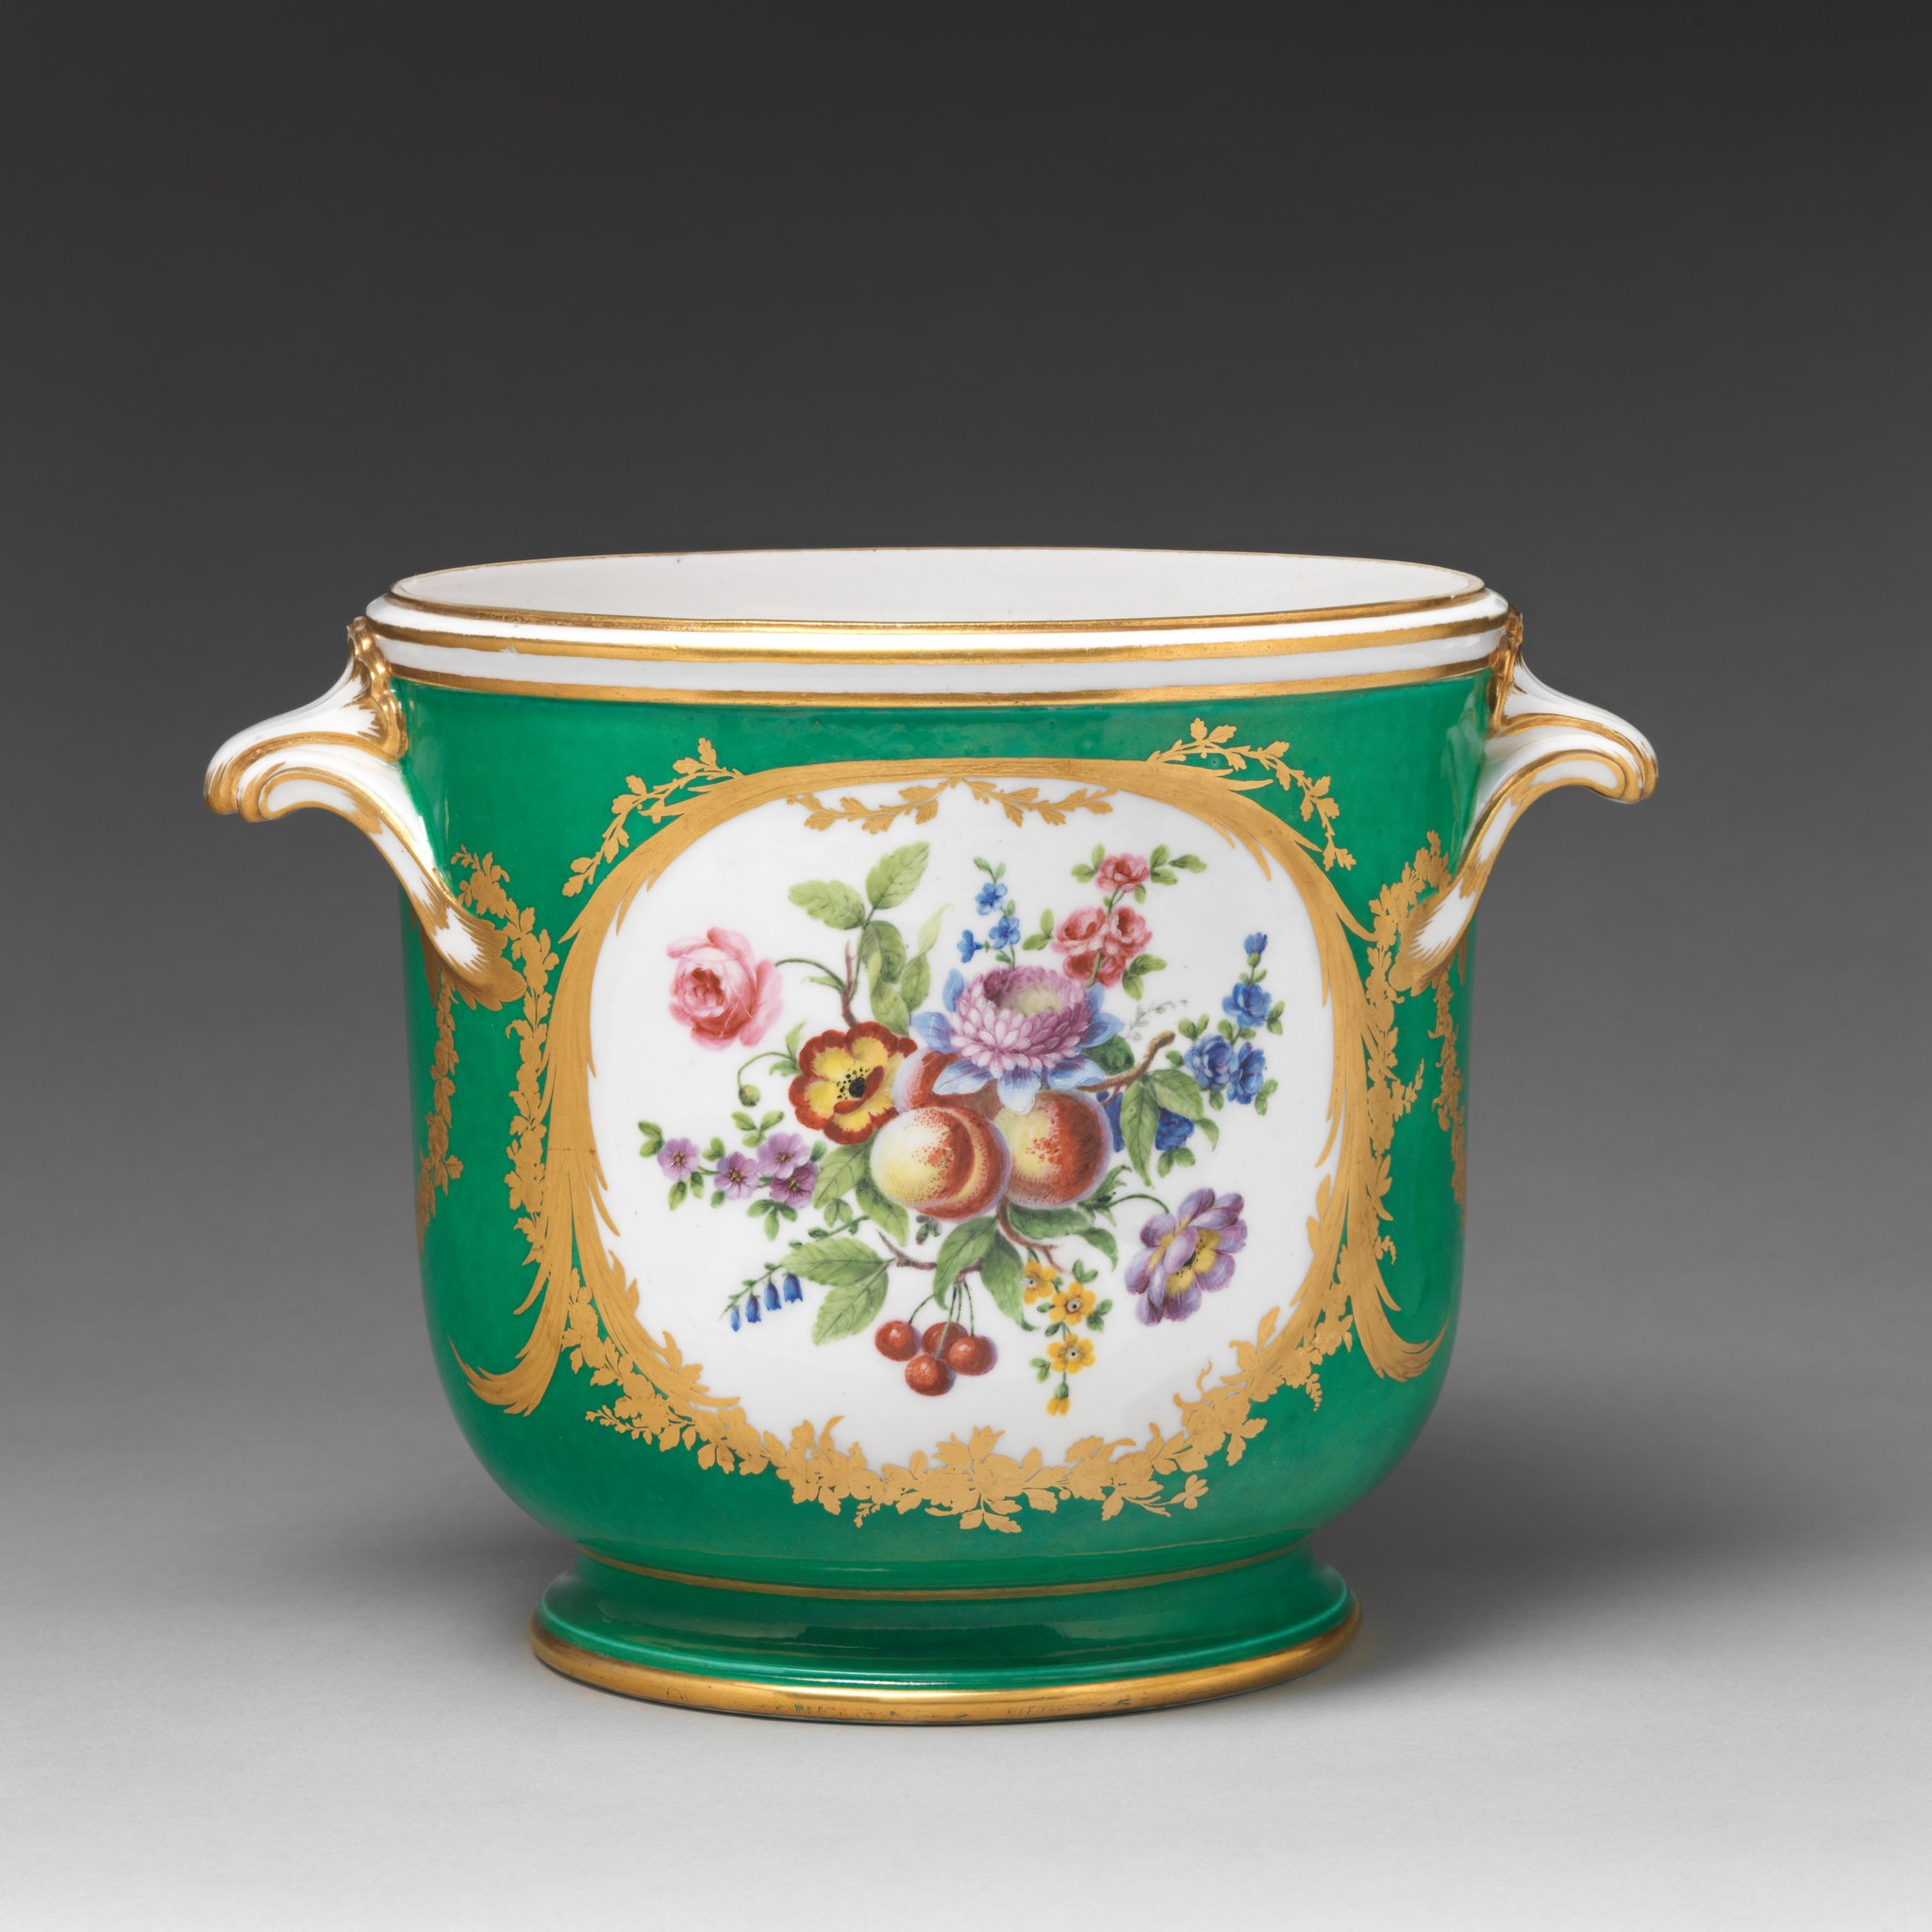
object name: bottle cooler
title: Bottle cooler (seau à bouteille) (part of a service)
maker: sèvres manufactory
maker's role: manufactory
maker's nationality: french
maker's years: 1740-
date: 1783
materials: soft paste porcelain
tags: fruit,flowers